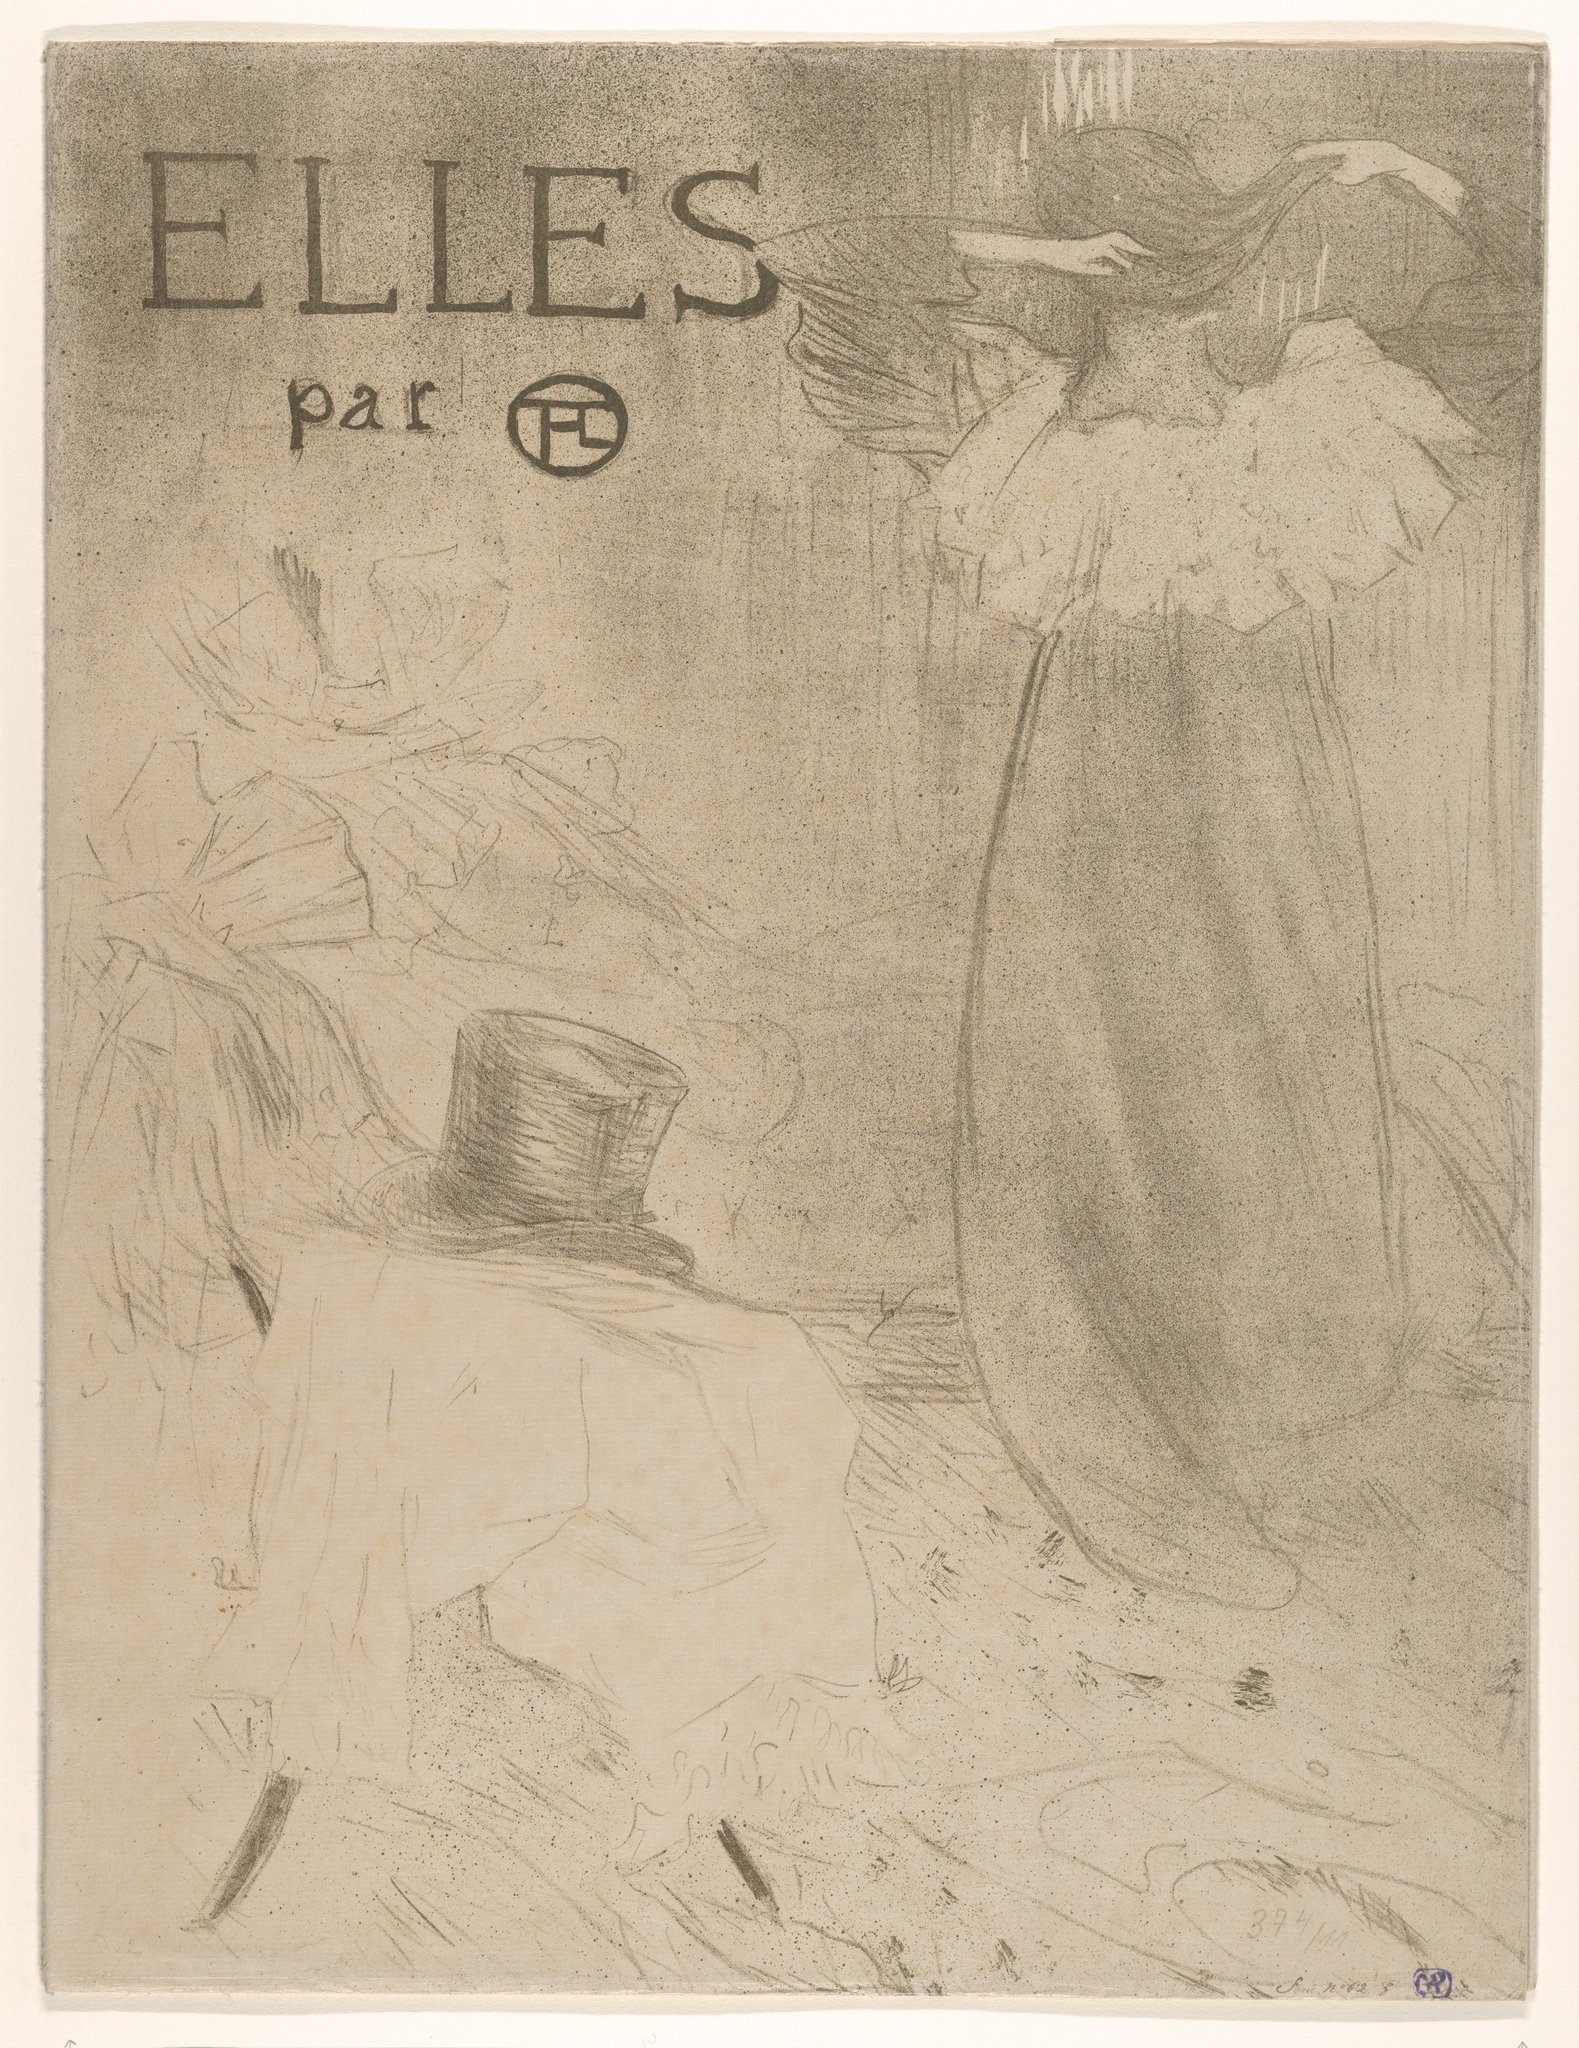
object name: print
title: Elles (portfolio cover)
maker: henri de toulouse-lautrec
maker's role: artist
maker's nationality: french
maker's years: 1864-1901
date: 1896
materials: crayon, paper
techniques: brush, lithograph, printing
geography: france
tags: hats,women